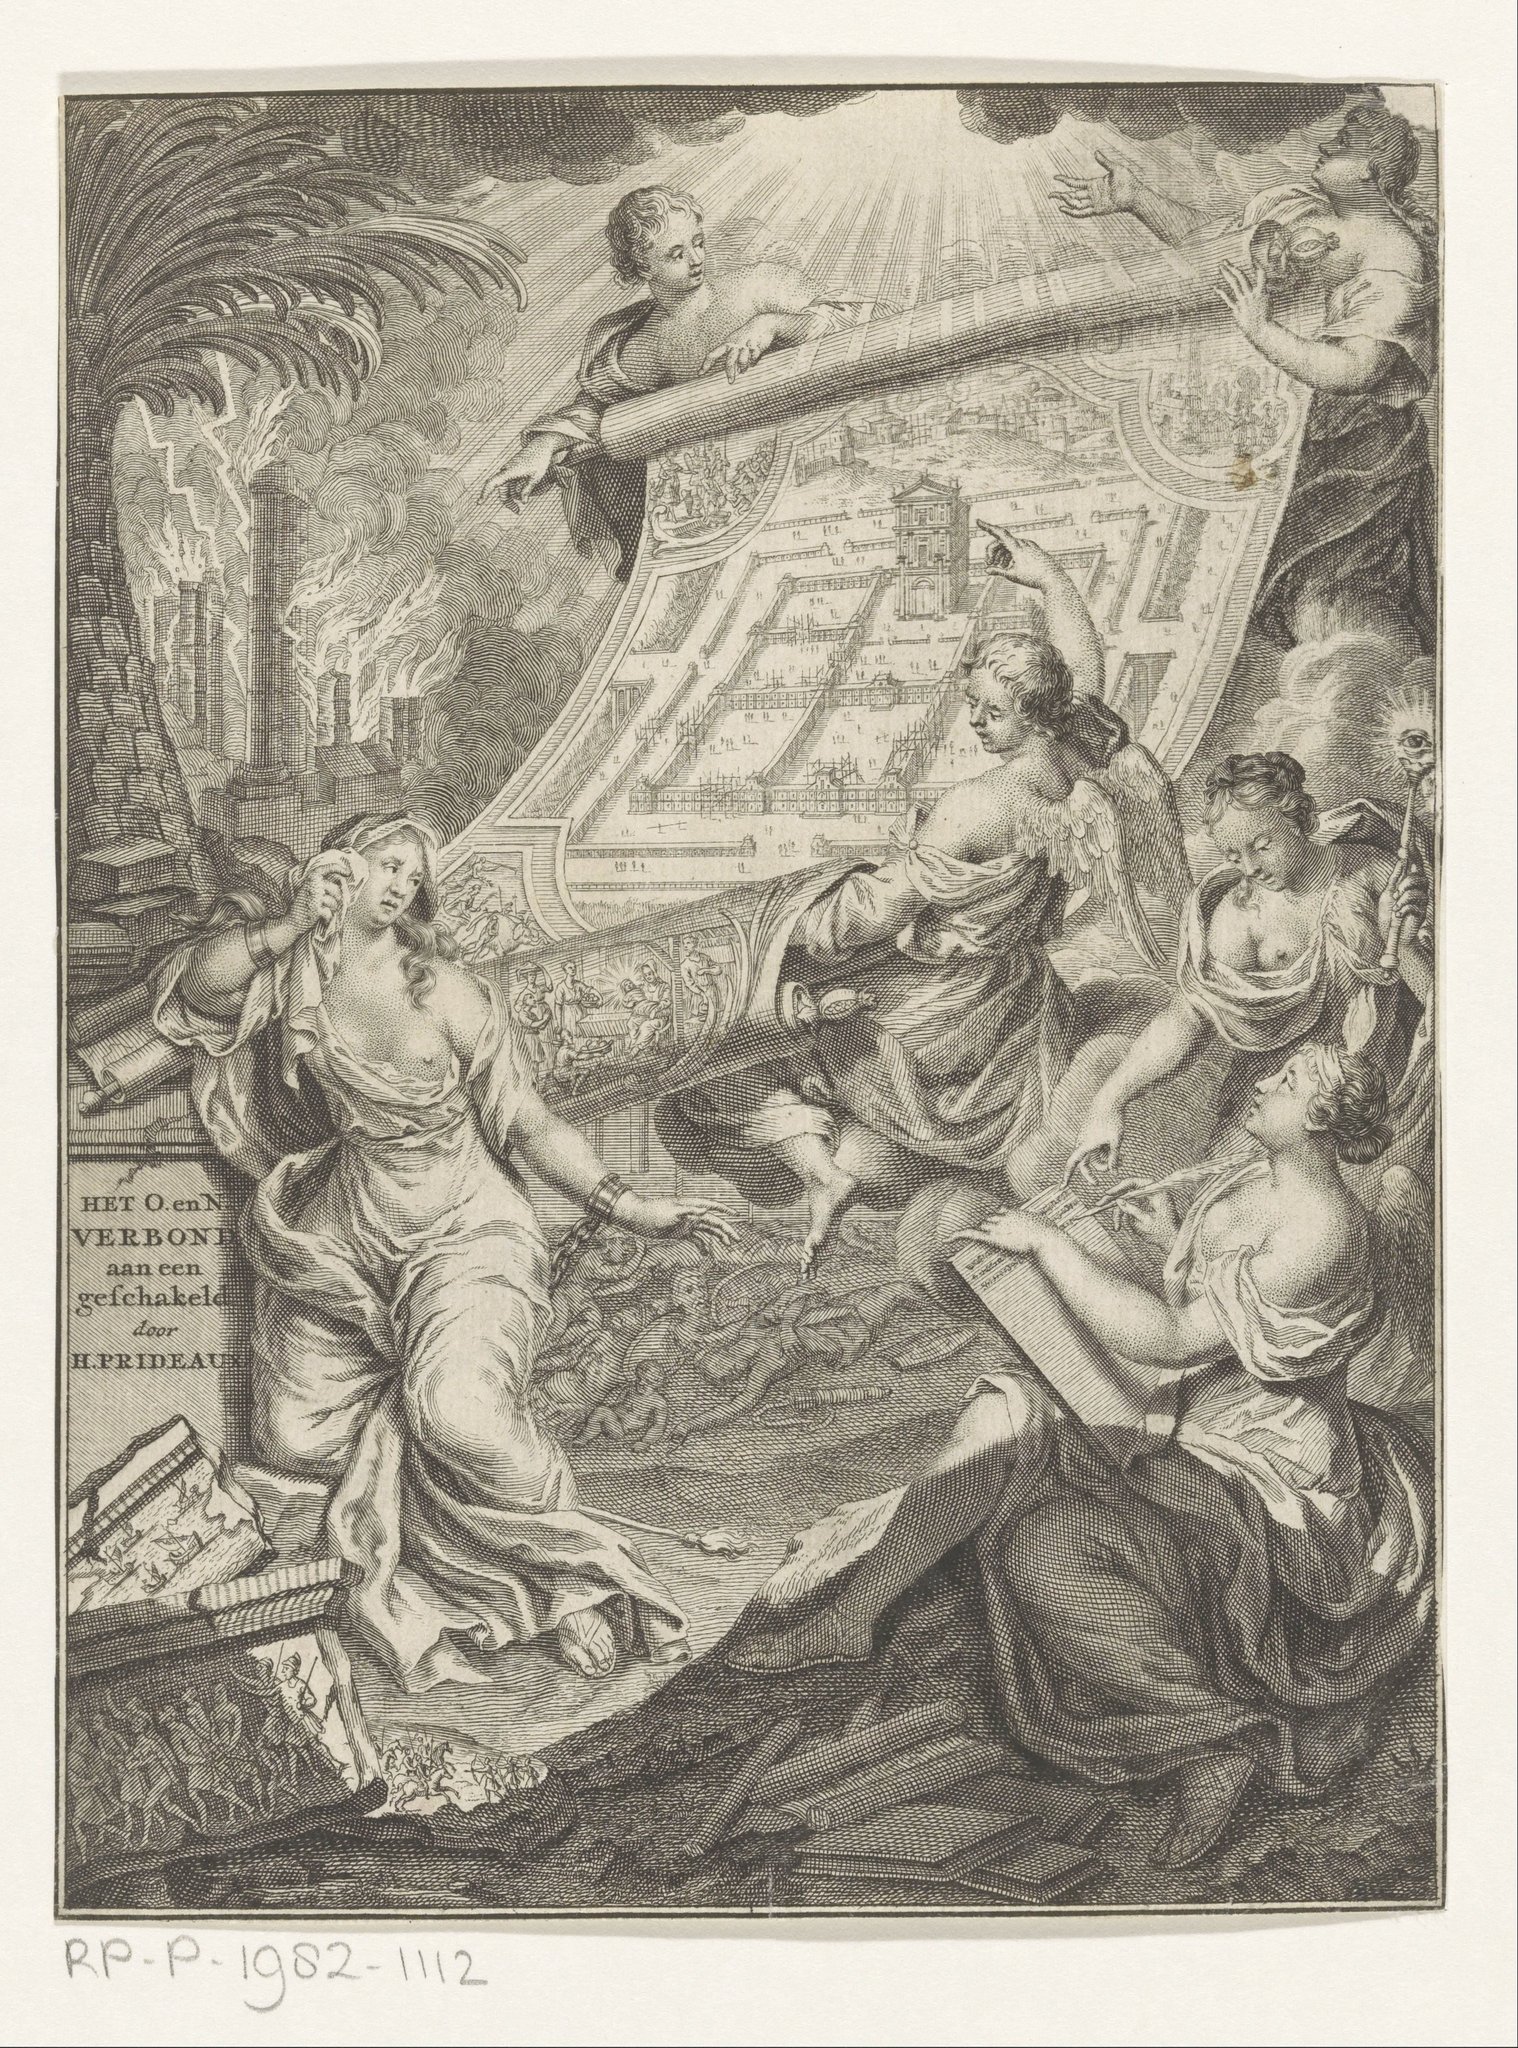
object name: print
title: Het O. en N. verbond aan een geschakeld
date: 1723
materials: paper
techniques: engraving, etching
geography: leiden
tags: truth; 'verità' (ripa), 'historia'; 'historia' (ripa), angels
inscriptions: collector's mark: Lugt 2760, collector's mark: Lugt 2228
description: Allegorie met vrouwelijke personificaties van de waarheid en geschiedenis (Historia) zittend tegenover een geketende vrouw, mogelijk de ondeugd. Engelen dragen een rolprent met afbeelding van de tempel van Jeruzalem. Op de achtergrond brandt een heidense tempel.